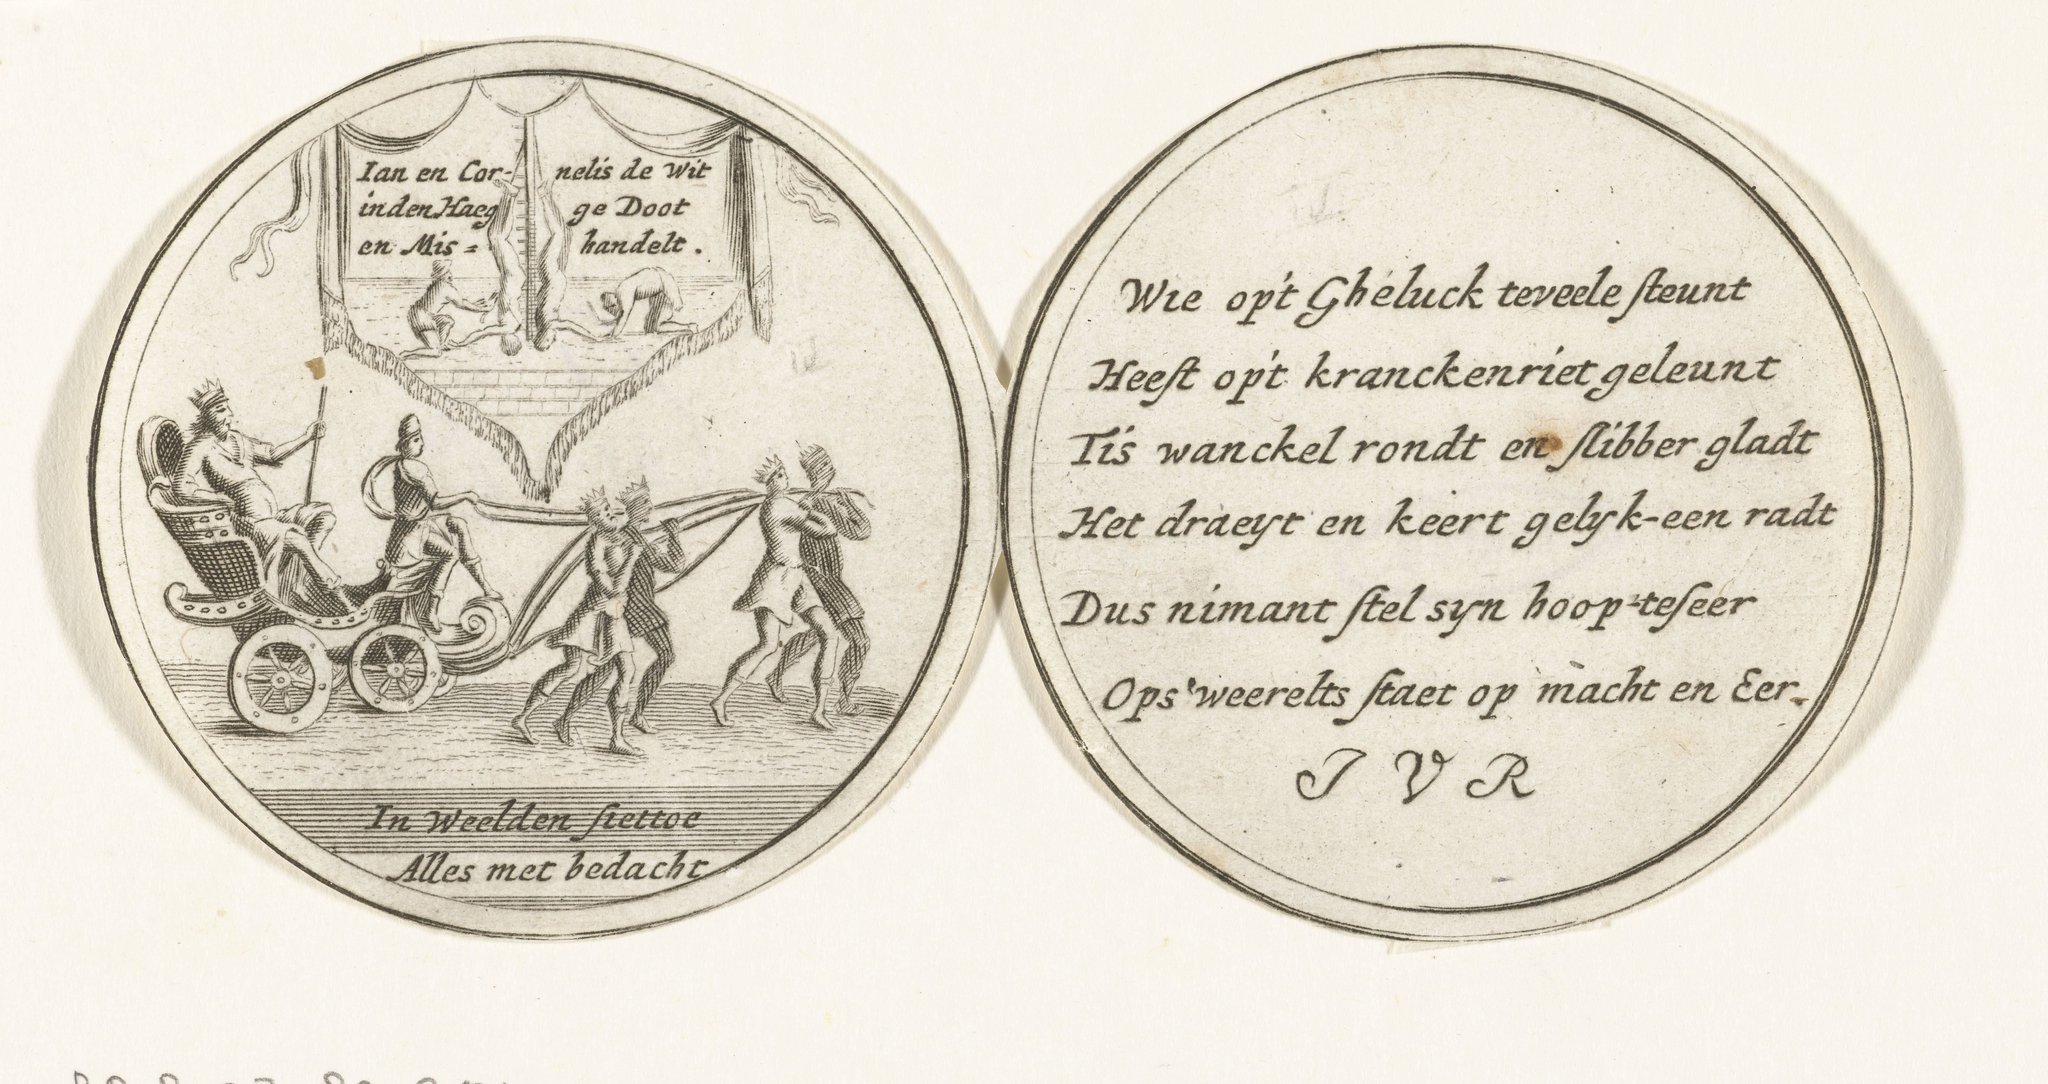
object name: print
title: Penning op de dood van de gebroeders De Witt, 1672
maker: Anonymous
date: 1672-1699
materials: paper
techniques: engraving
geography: northern netherlands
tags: dordrecht, cornelis de witt, the hague, politician, johan de witt, medal (considered as a piece of sculpture, regardless of its specific function)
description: Voor- en keerzijde van een penning ter ere van de gebroeders Johan en Cornelis de Witt, vermoord op 20 augustus 1672, uitgeknipt. Voorzijde: een vorst in zijn triomfwagen getrokken door koningen met erboven een scène van de verminking van de lichamen. Keerzijde: een vers van zes regels gesigneerd J.V.R.